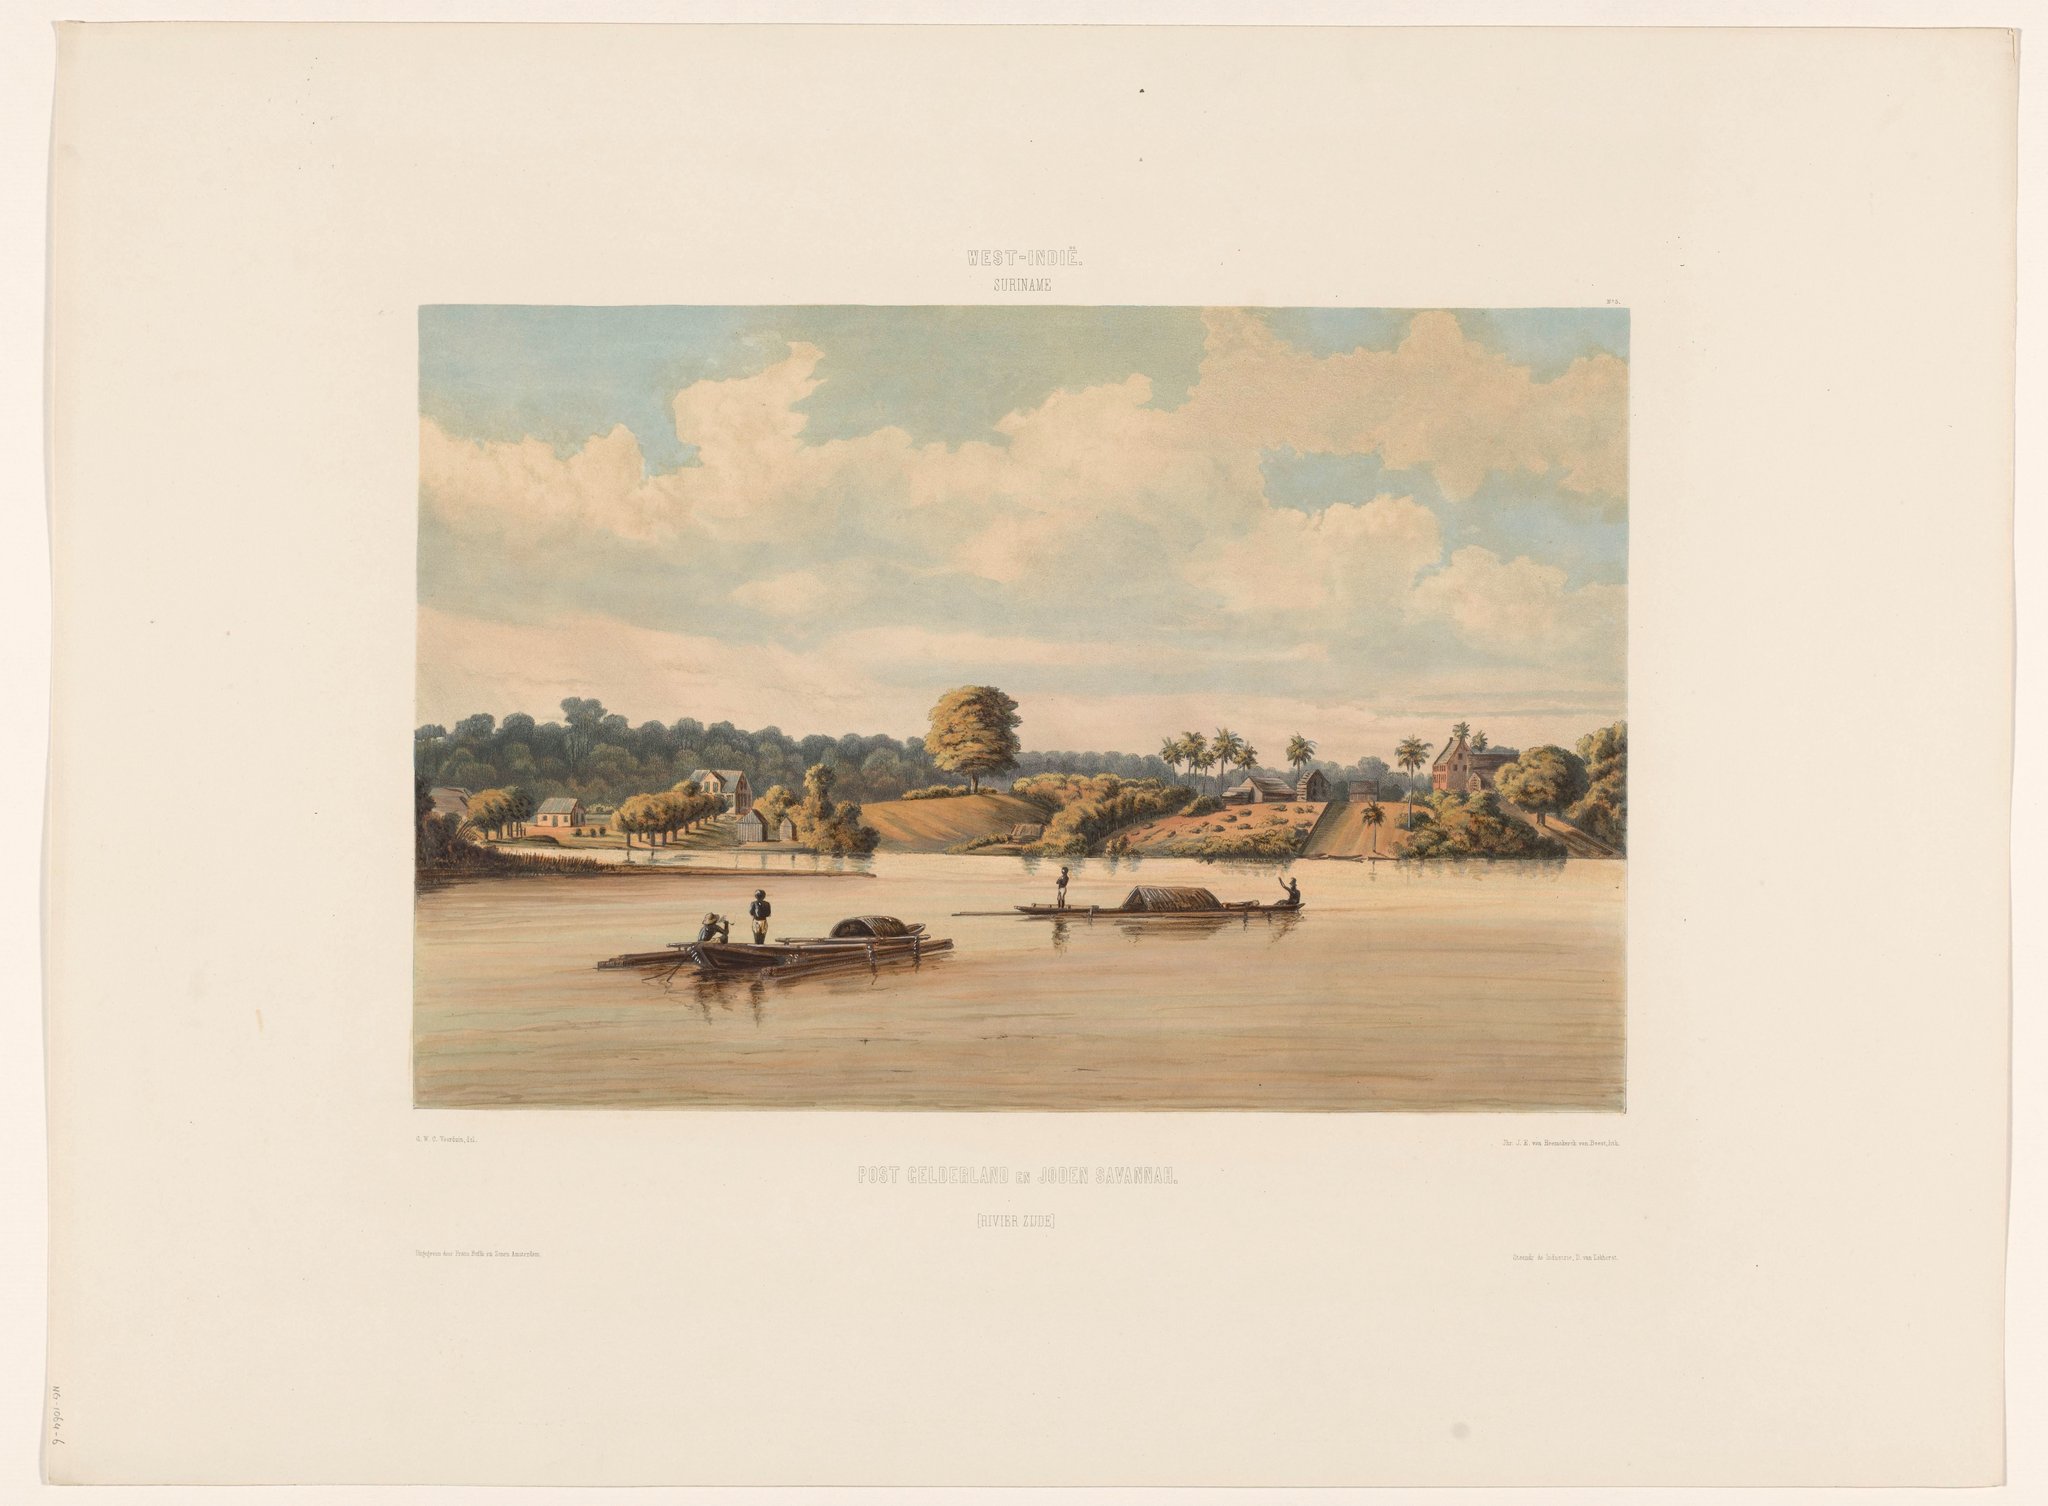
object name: print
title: Post Gelderland en Joden Savannah (rivier zijde)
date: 1860-1862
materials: paper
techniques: lithograph, hand coloring, lacquer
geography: amsterdam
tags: river (+ landscape with figures, staffage), suriname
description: Gezicht vanaf de Surinamerivier op de Jodensavanna en de militaire Post Gelderland. Op de rivier enkele vaartuigen. Onderdeel van het plaatwerk 'Gezigten uit Neerland's West-Indien'.